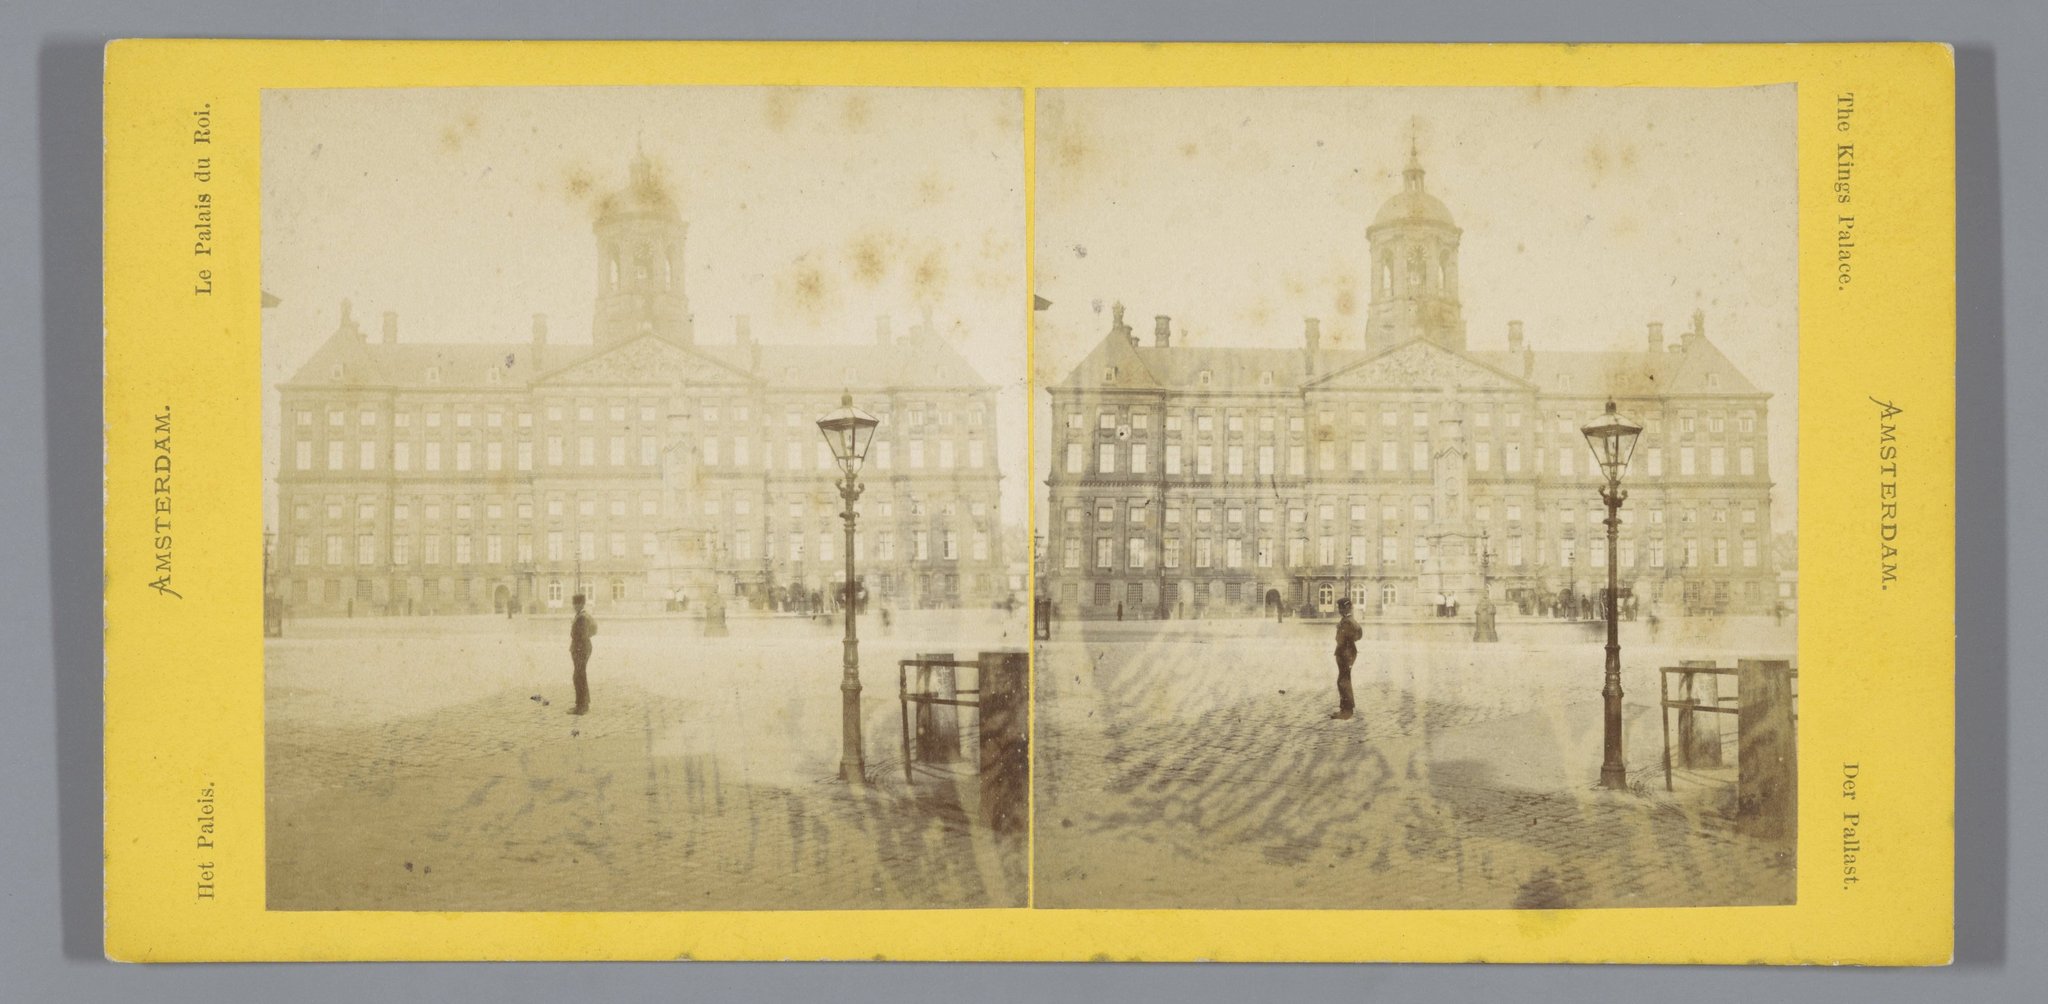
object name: stereograph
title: Het Paleis; Le Palais du Roi; The Kings Palace; Der Pallast.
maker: Anonymous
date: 1861-1870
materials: cardboard, paper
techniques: albumen print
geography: amsterdam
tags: square, place, circus, etc., palace, royal palace of amsterdam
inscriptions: inscription: ‘H [...], Paleis op de Dam’